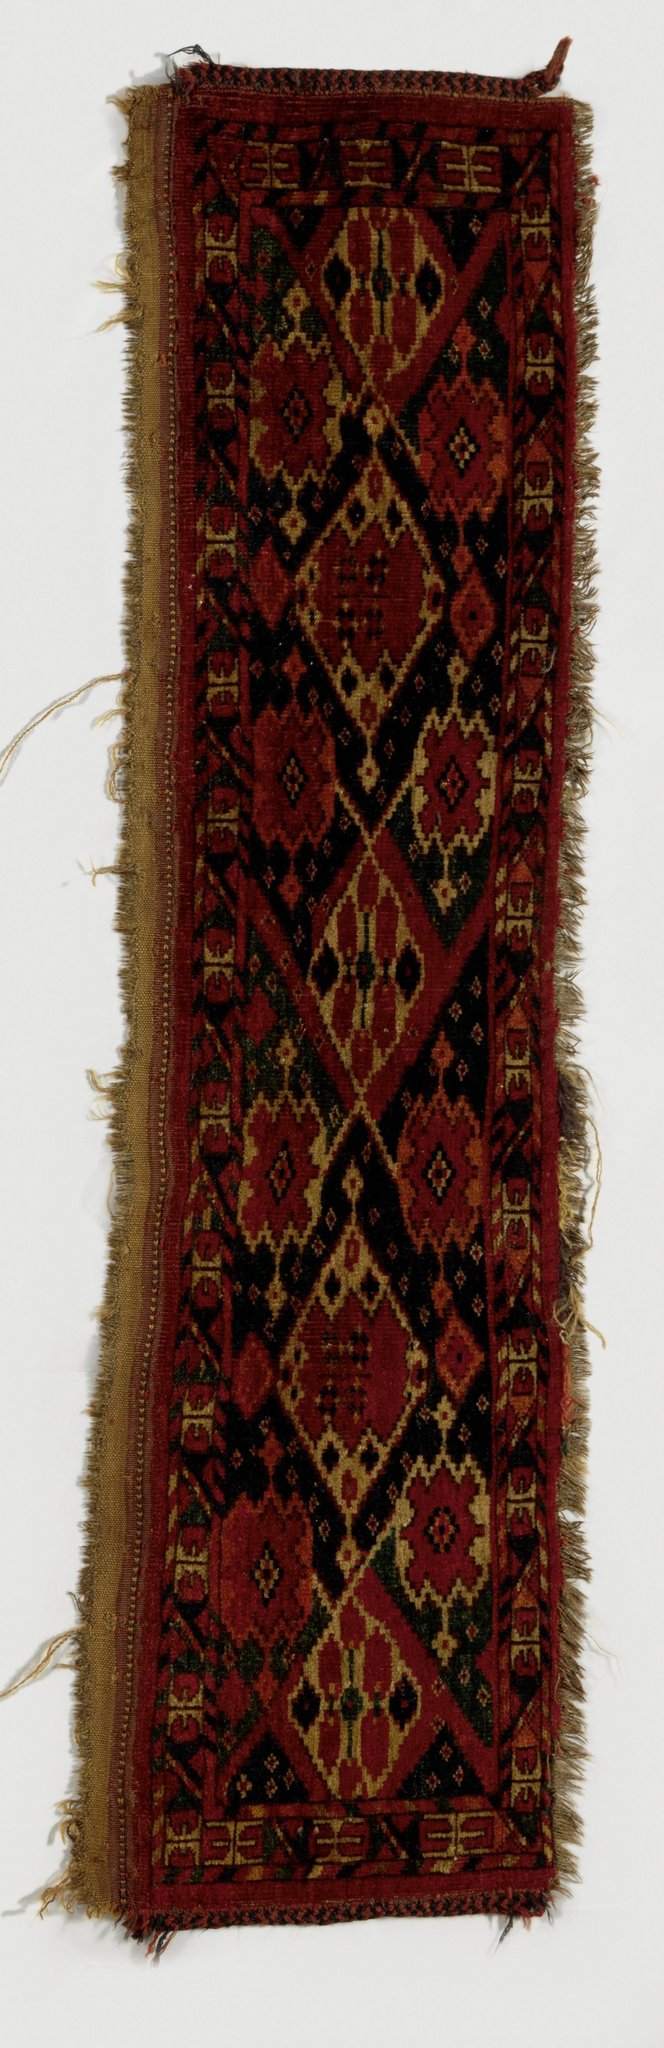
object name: oriental rug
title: Dekkleed voor een kameel.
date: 1875-1900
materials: wool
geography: turkestan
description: Dekkleed voor een kameel. Het middenveld is versierd met ruiten waaruit vier bloemen komen. Rand versierd met cartouches en bloemen op rechthoeken.